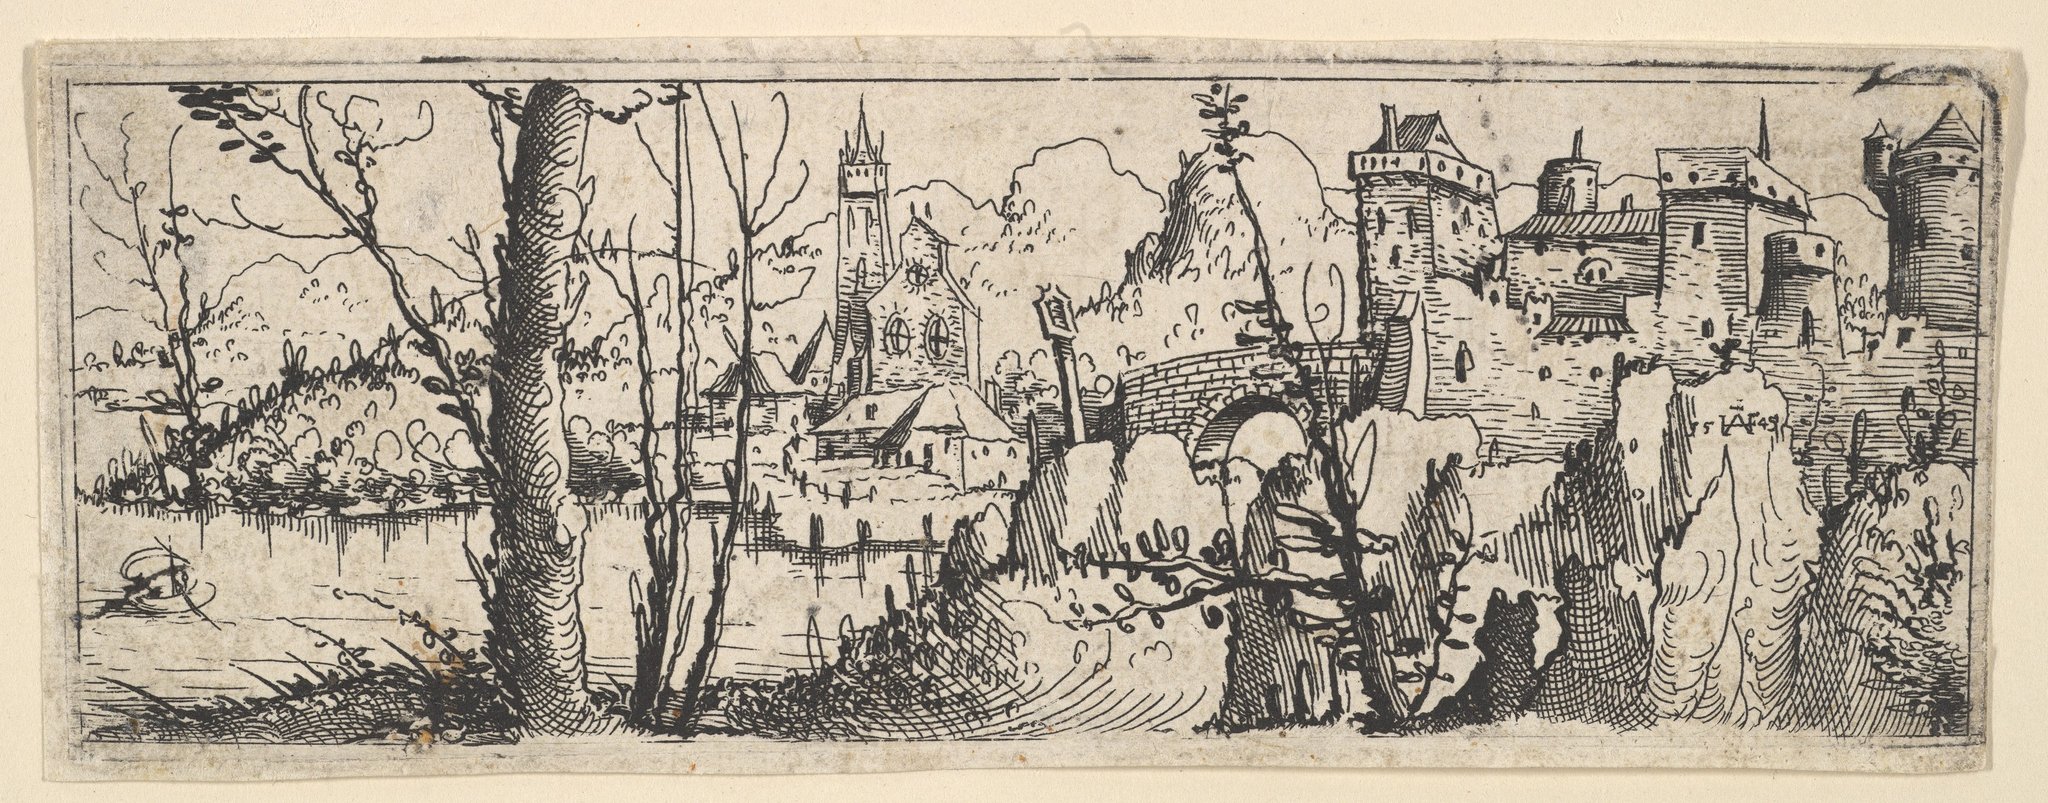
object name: print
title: Landscape with Fort and a Church on a River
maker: augustin hirschvogel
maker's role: artist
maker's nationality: german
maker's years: 1503-1553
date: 1545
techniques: etching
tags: castles,churches,rivers,landscapes